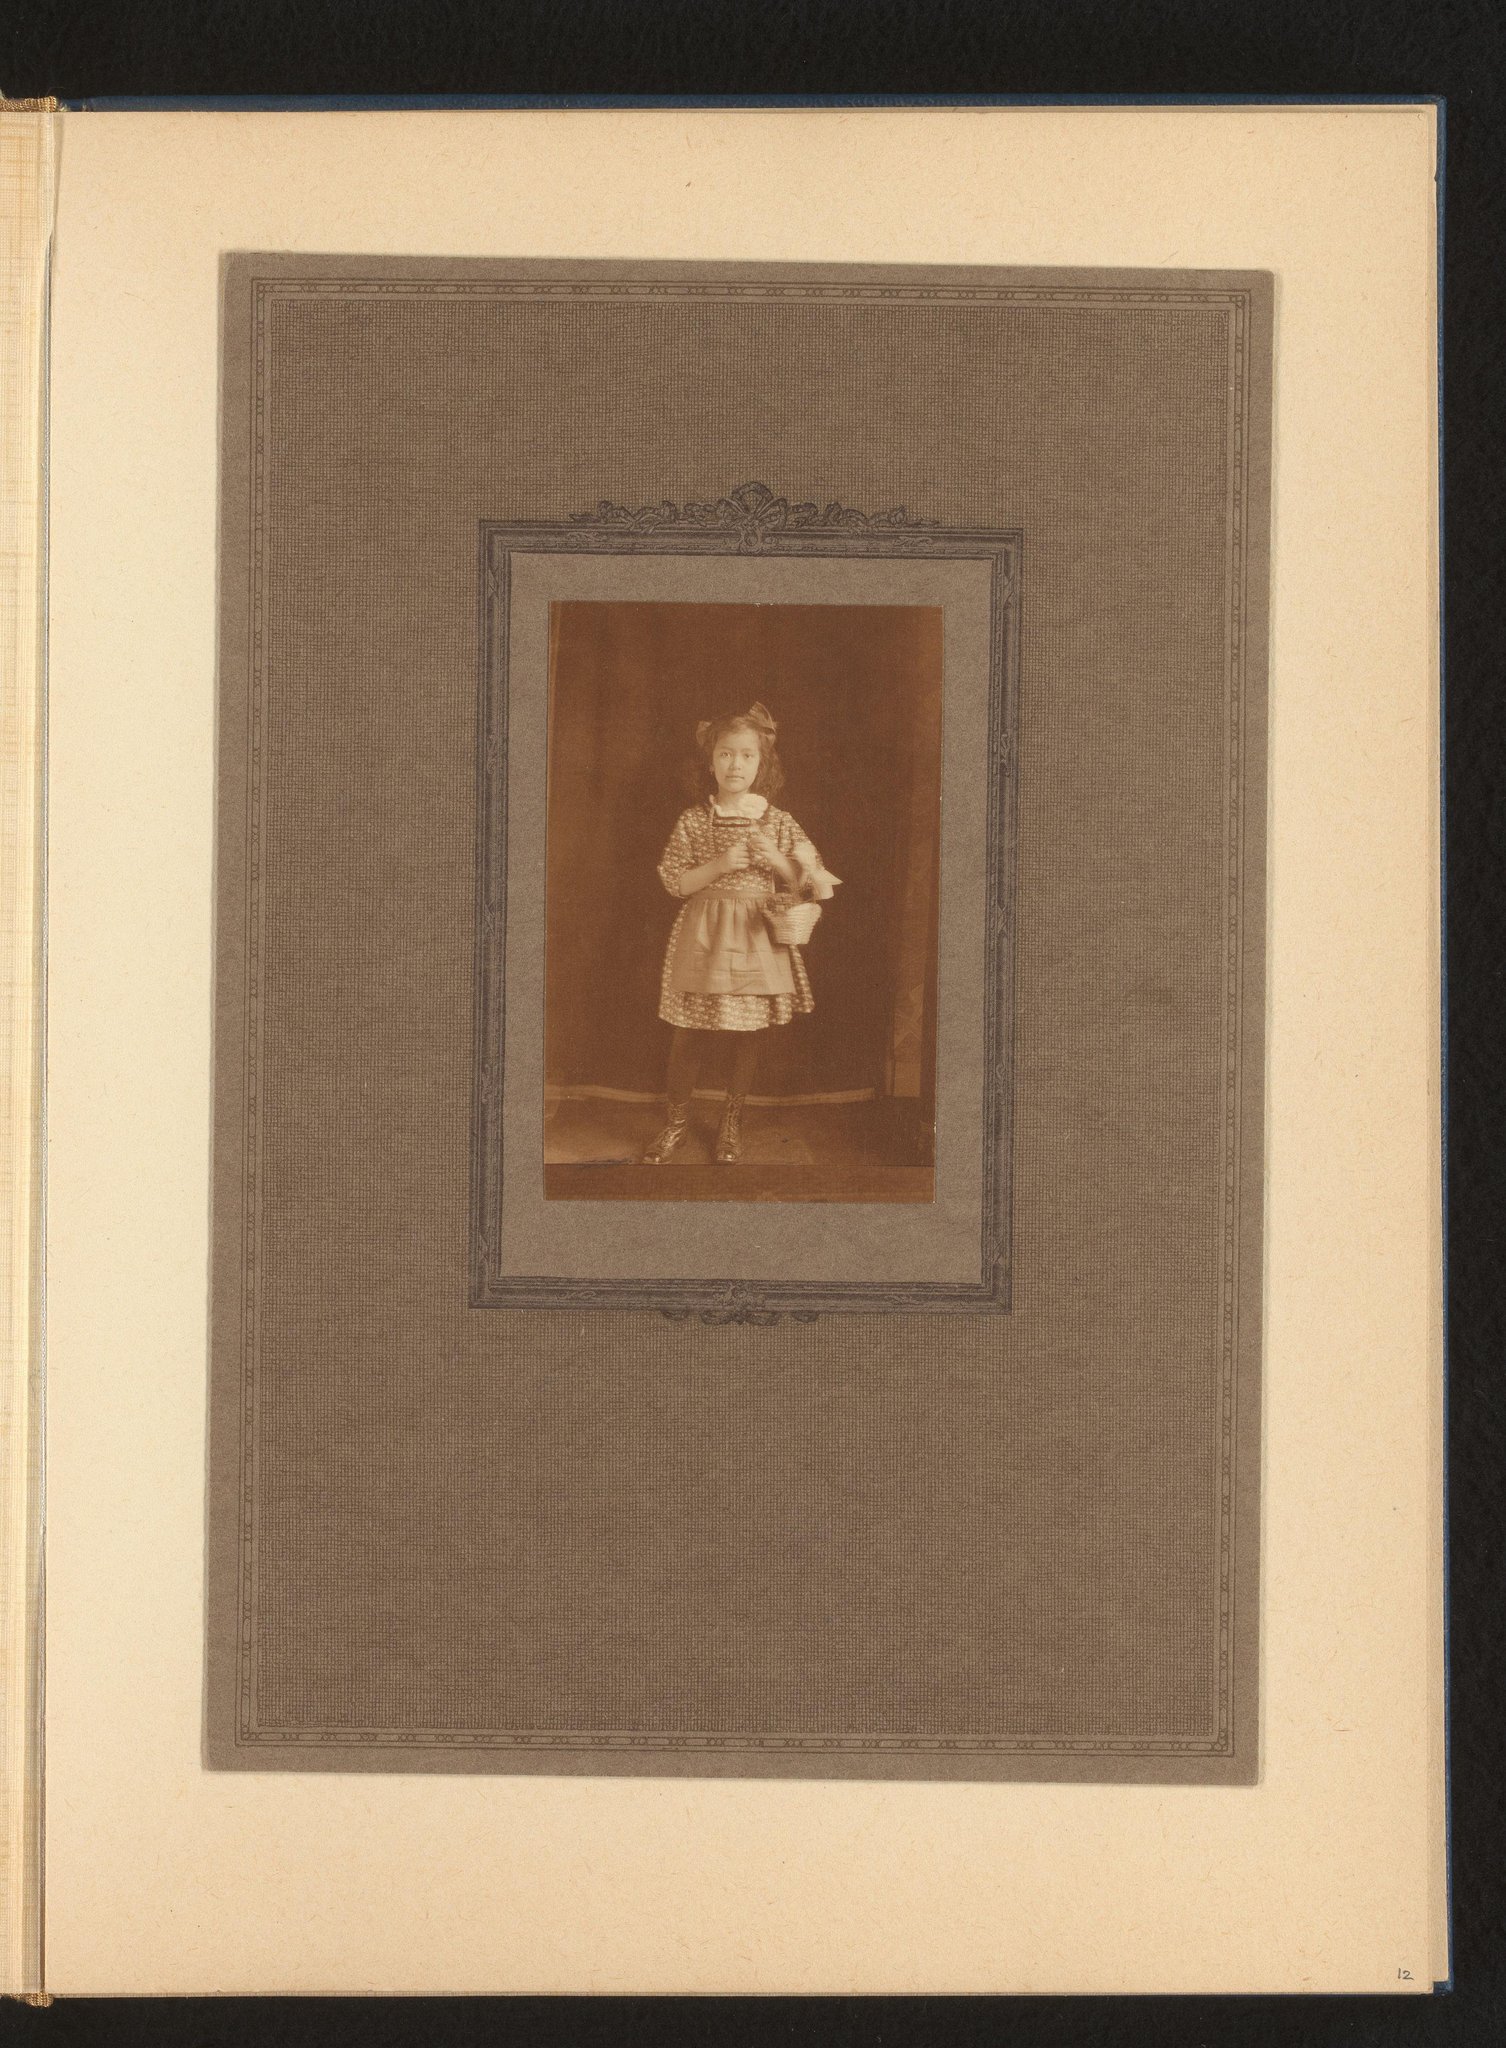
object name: photograph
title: Portret van Eef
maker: Anonymous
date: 1920-1925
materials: cardboard, photographic support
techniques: matte daylight collodion silver print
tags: paris, beatrice jacqueline eveline dumas, historical persons - bb - woman, girl (child between toddler and youth), family life at home, netherlands, dutch east indies, the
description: Portret van Eef Dumas, staande met een bloem en een mandje aan de arm. Onderdeel van het fotoalbum van Beatrice Jacqueline Eveline (Eef) Dumas, ca. 1880-1952.